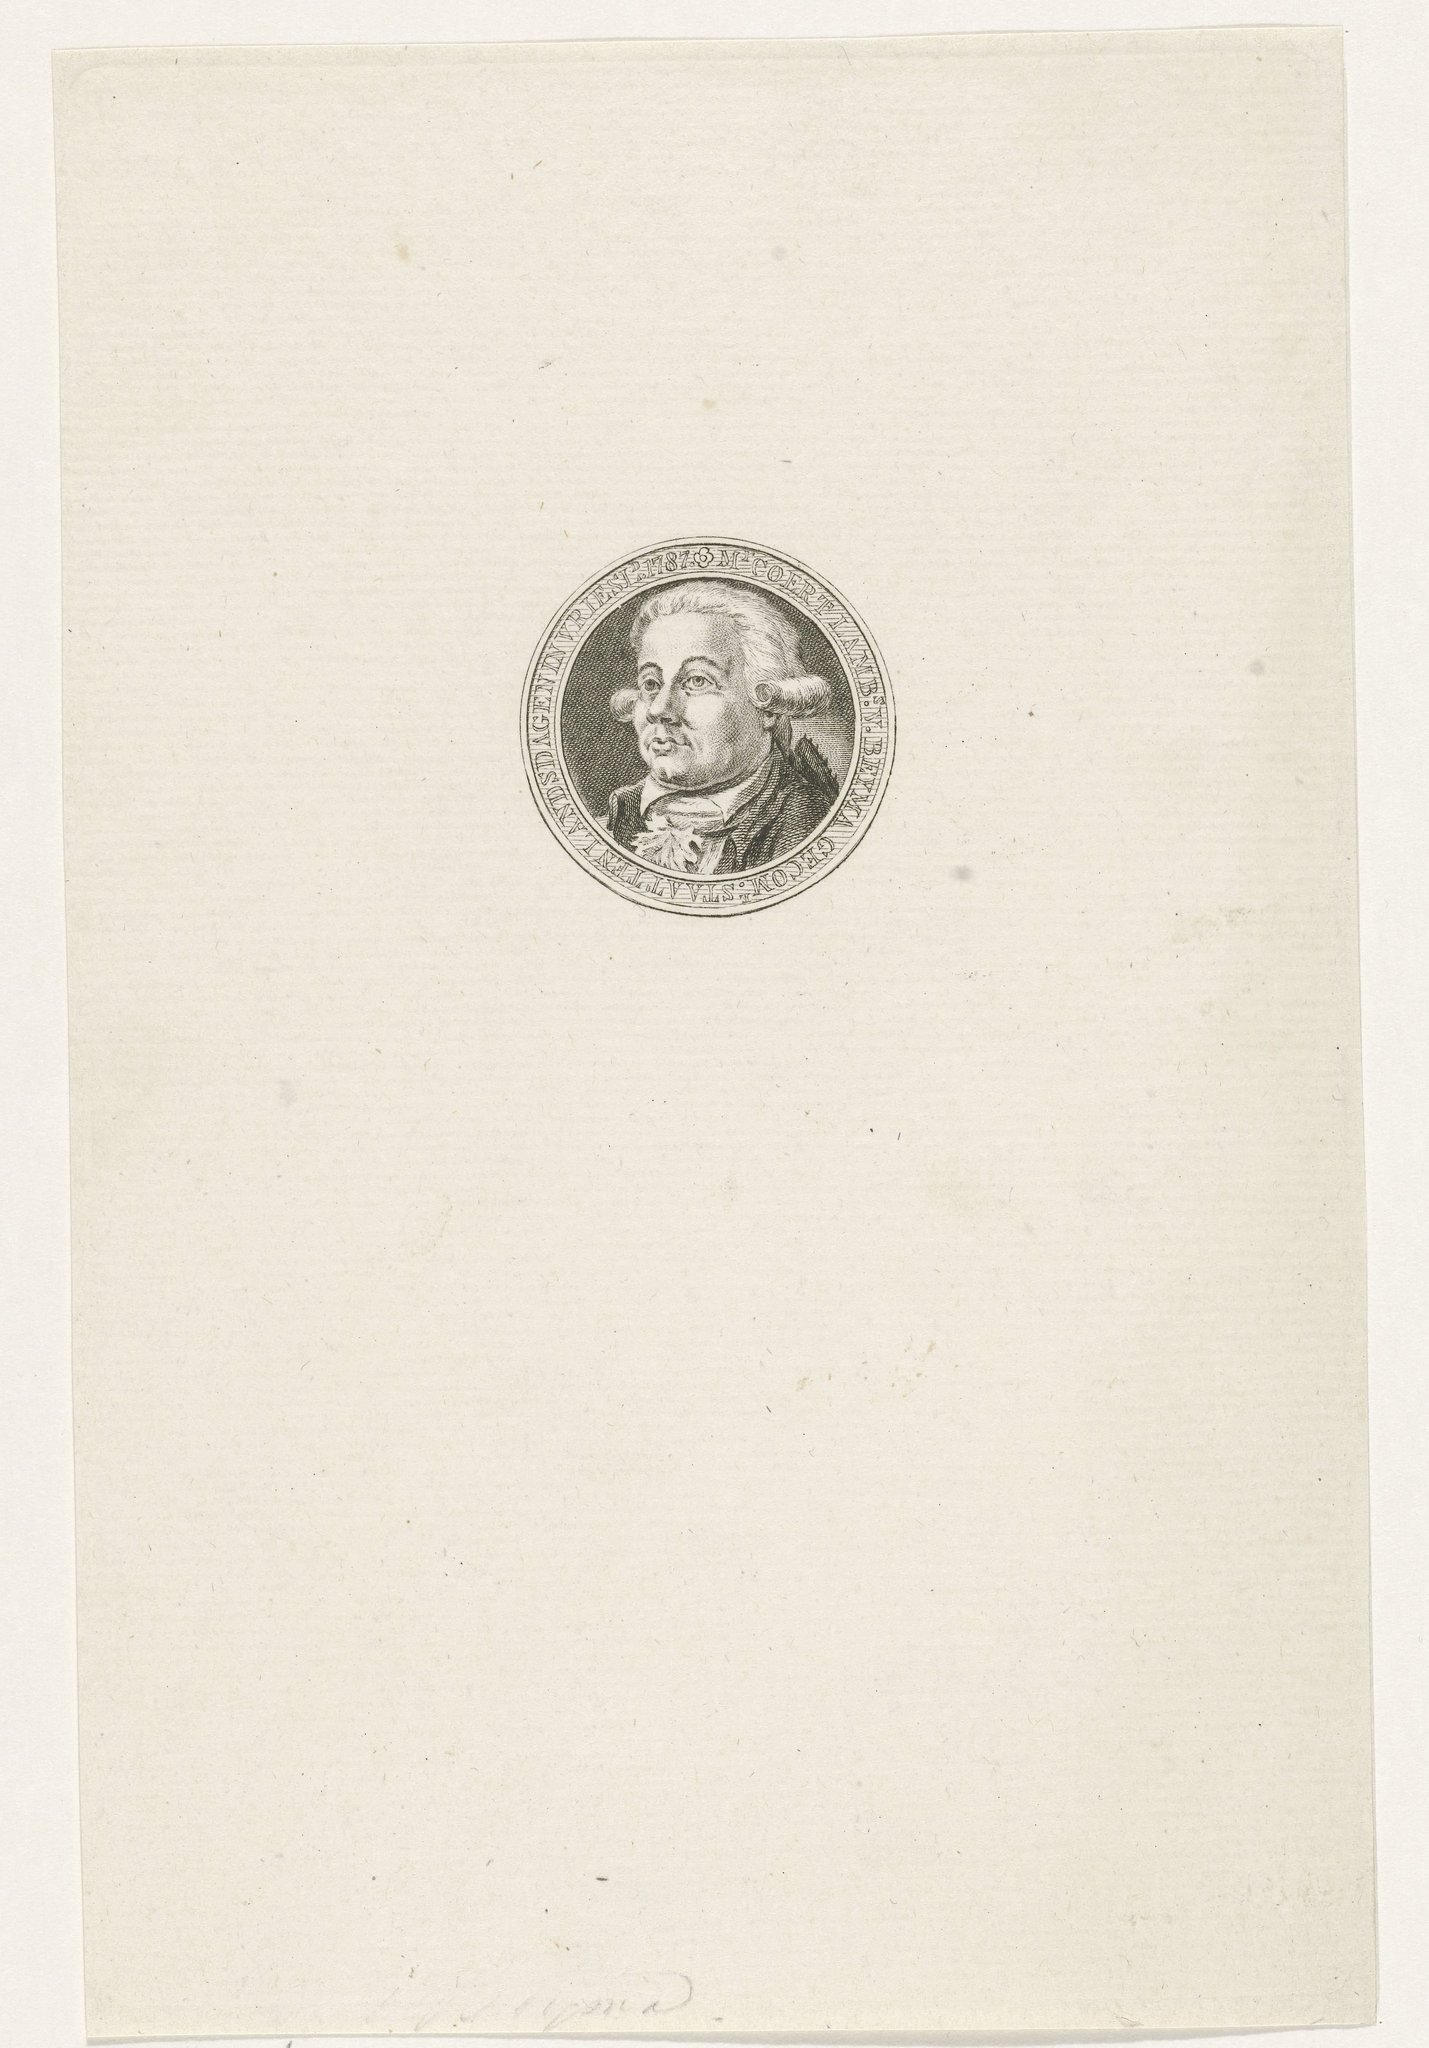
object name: print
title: Portretten van patriotten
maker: abraham jacobsz. hulk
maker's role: print maker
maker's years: 1751-1817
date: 1787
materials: paper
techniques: engraving, etching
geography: paris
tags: harlingen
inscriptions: collector's mark: Lugt 2228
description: Buste van Coert Lambertus van Beyma naar links in een medaillon met randschrift in het Nederlands.